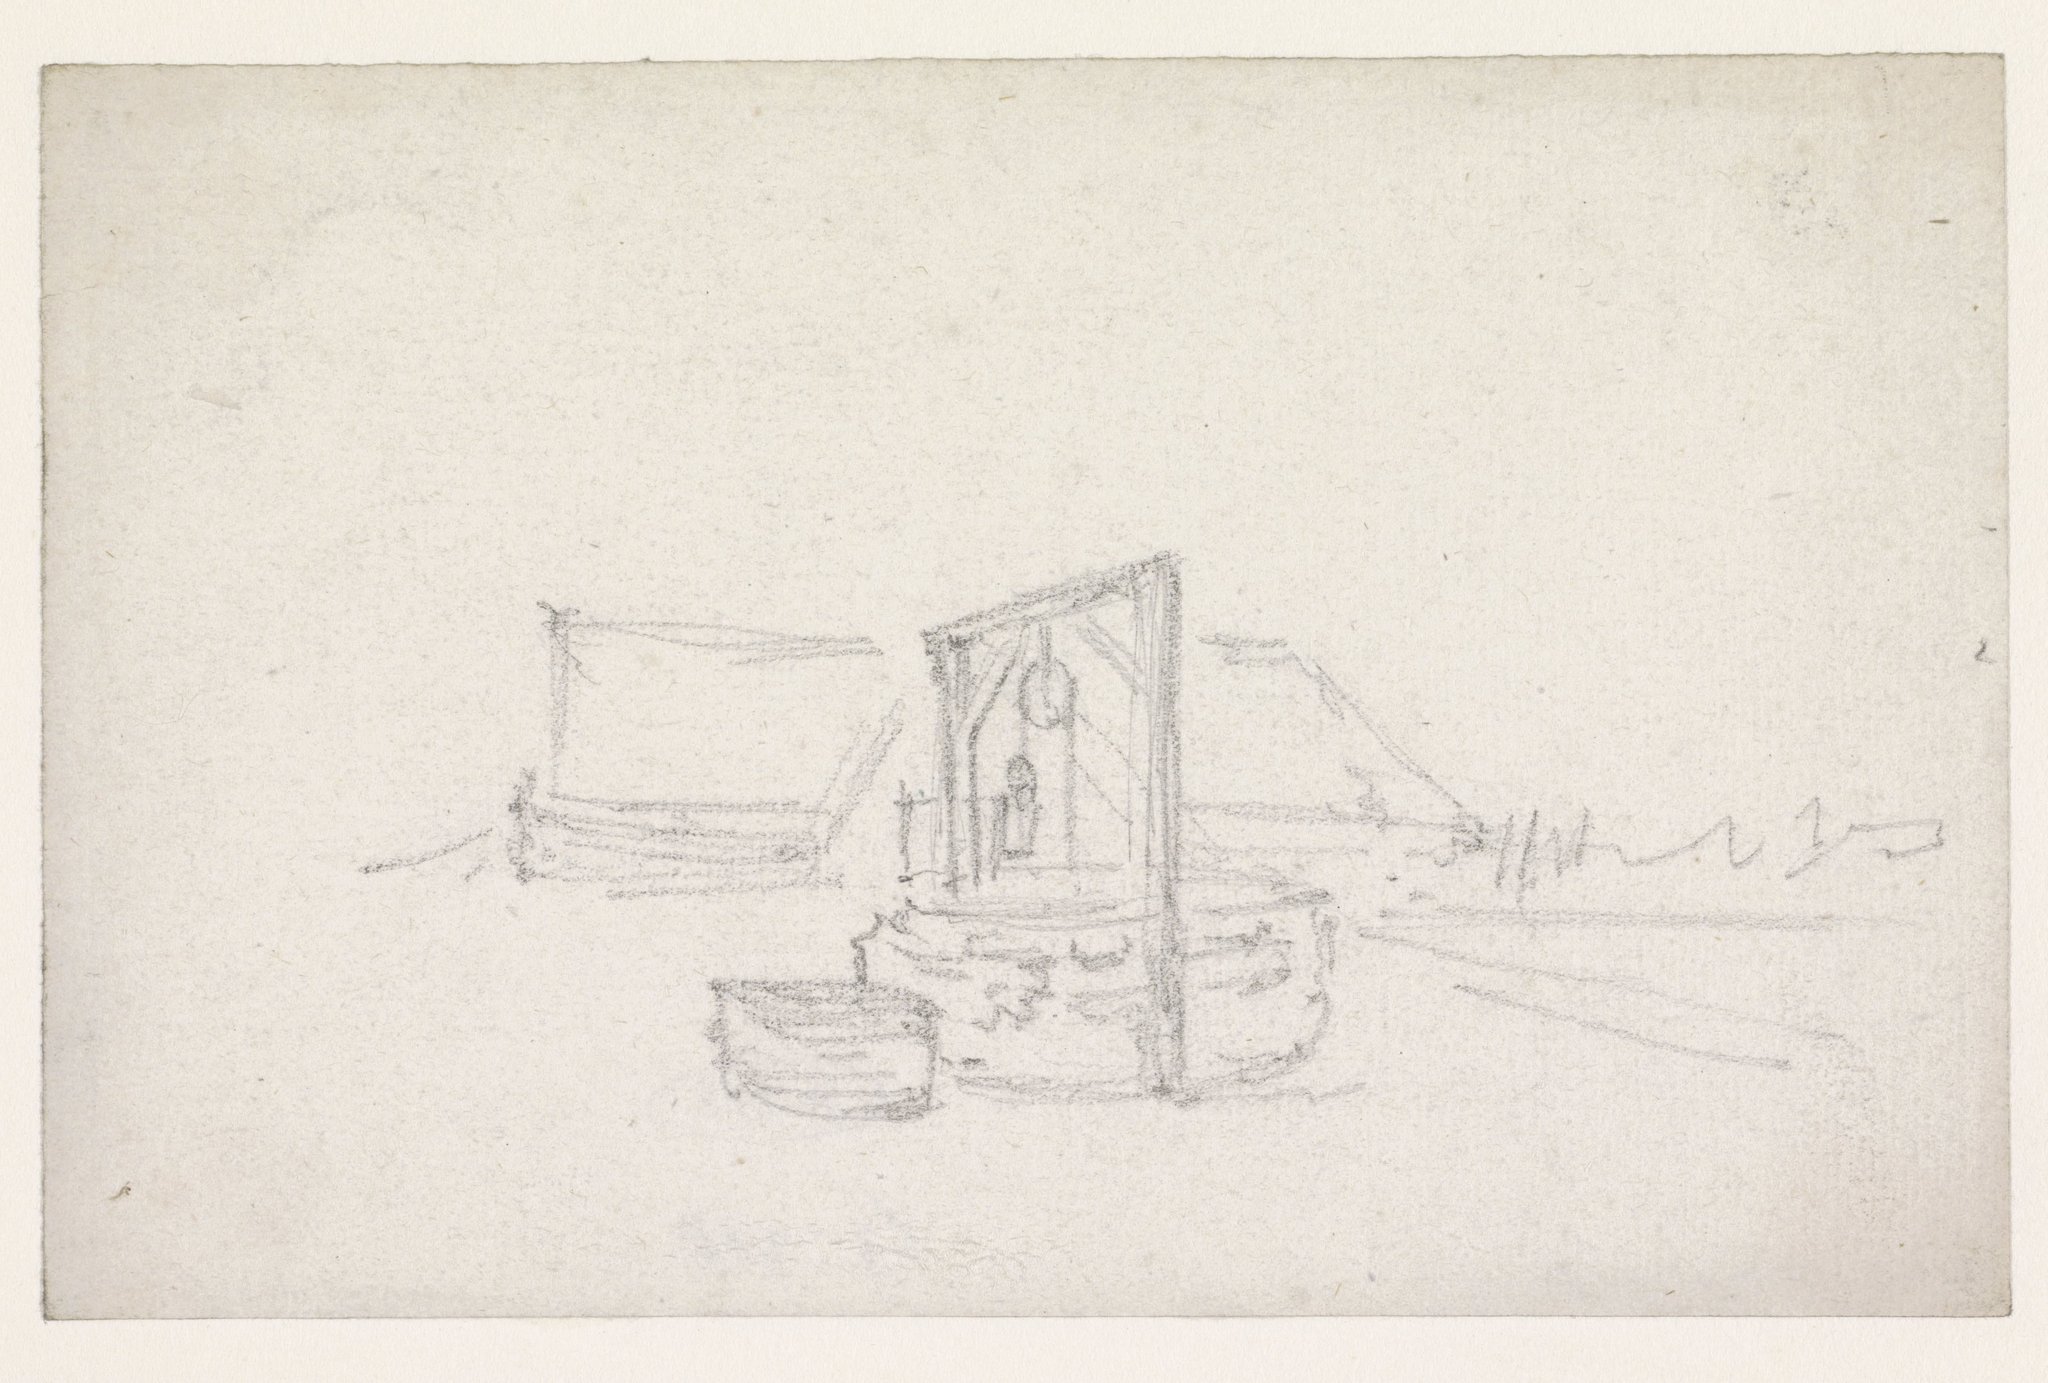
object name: drawing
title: Schets van een waterput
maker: georges michel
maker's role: draughtsman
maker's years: 1763-1843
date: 1773-1843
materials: paper, pencil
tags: well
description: Een van 120 tekeningen, afkomstig uit een 19e eeuws album met tekeningen van Georges Michel.